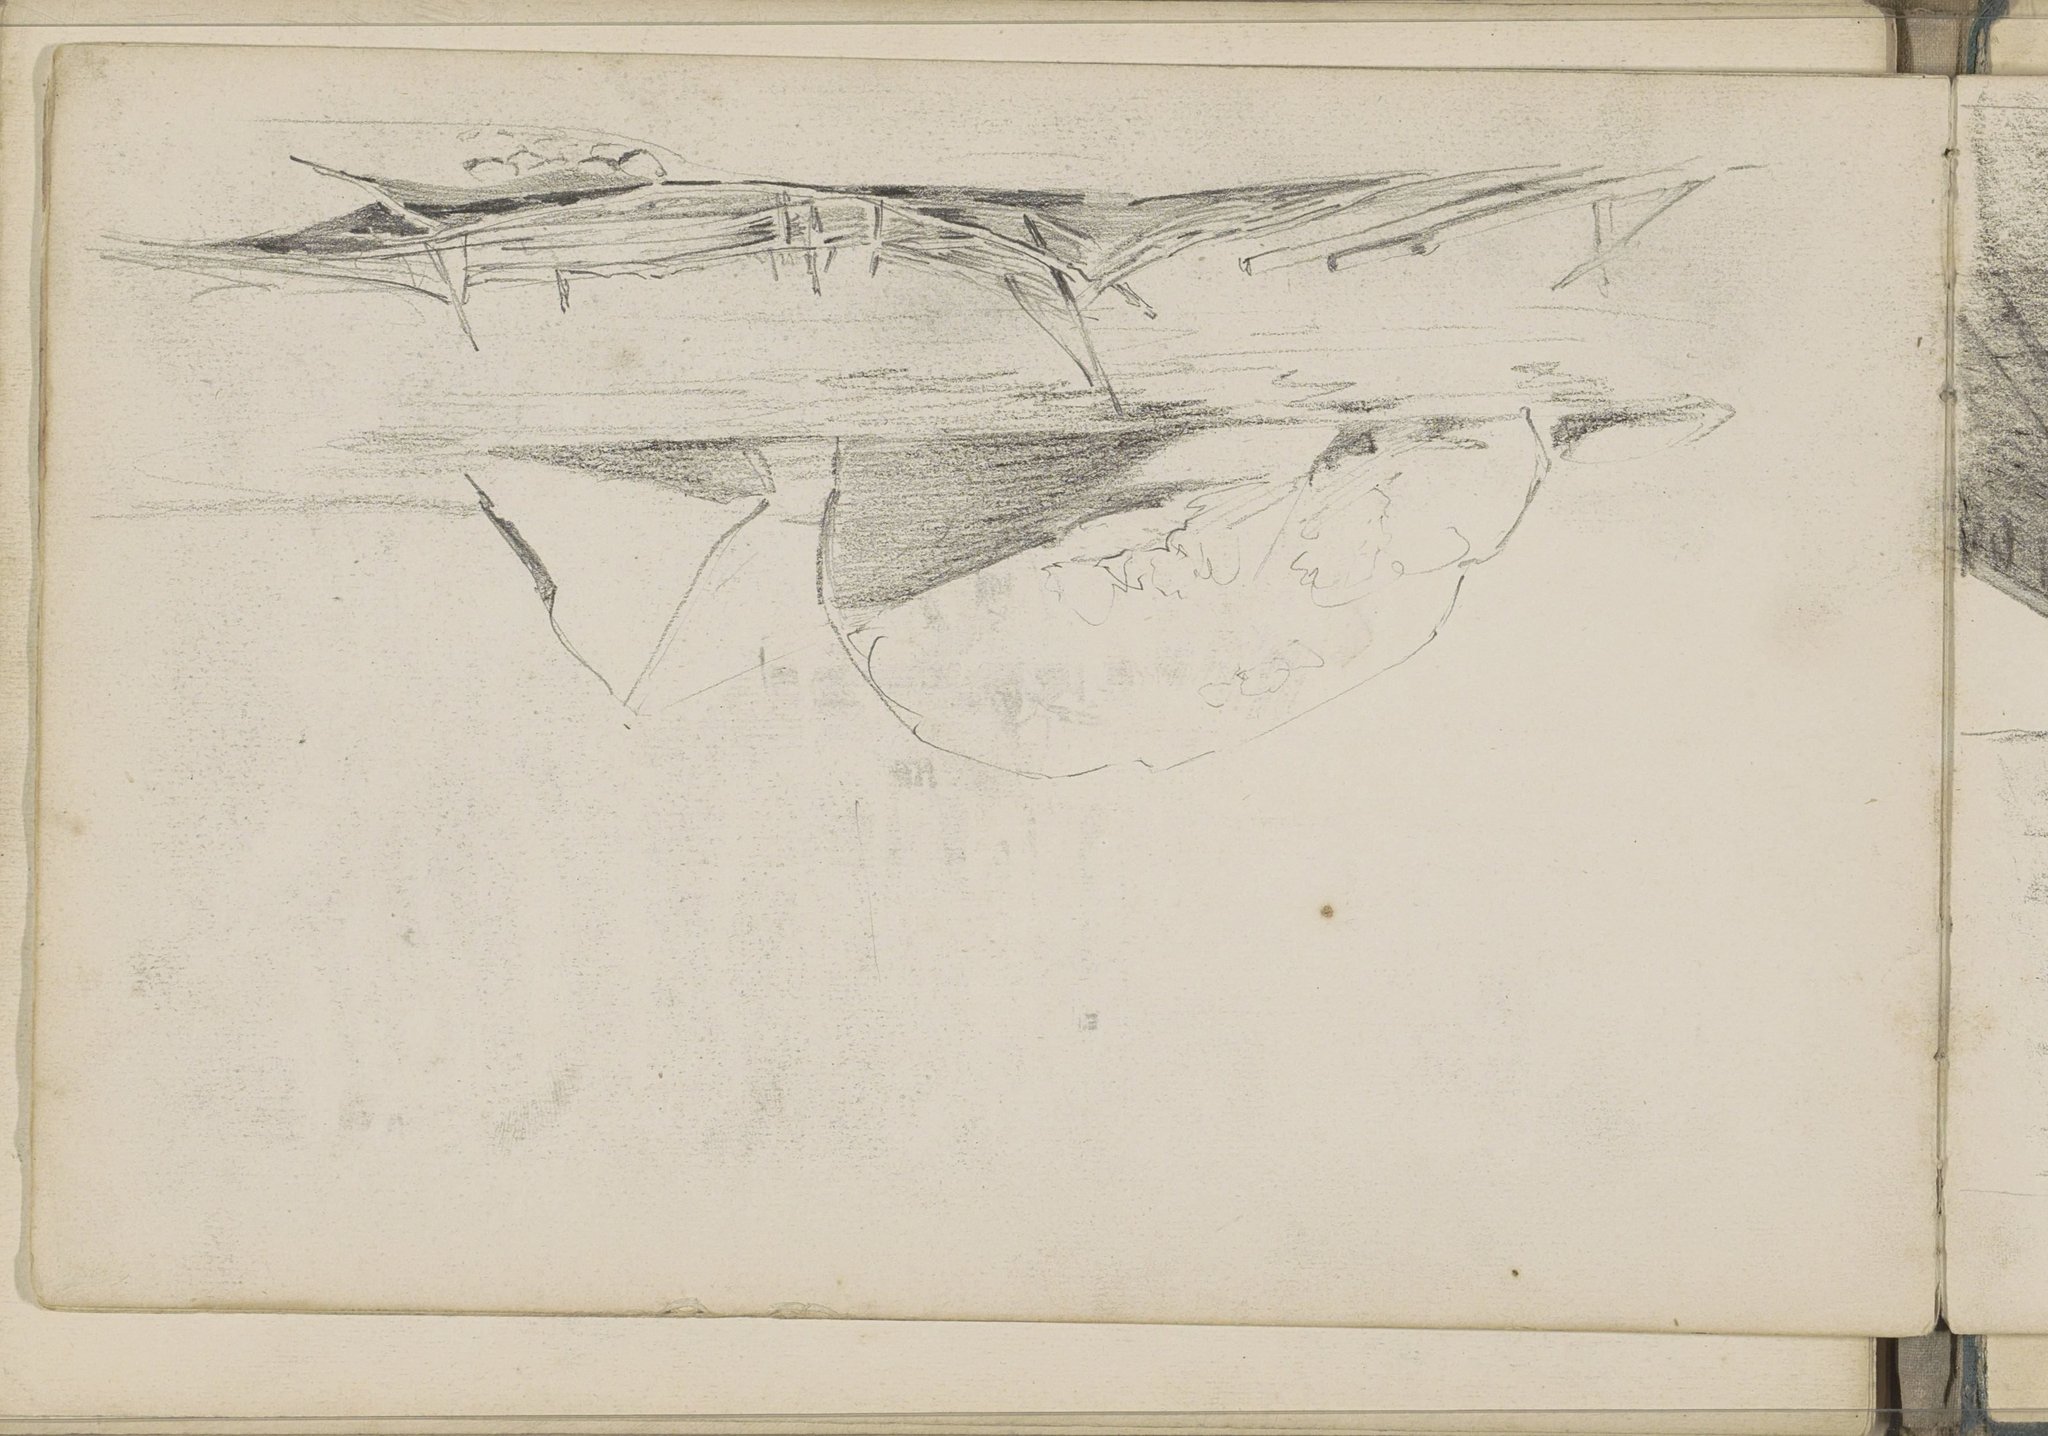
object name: sketchbook leaf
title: Landschap met keien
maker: willem cornelis rip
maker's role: draughtsman, painter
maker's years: 1856-1922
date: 1874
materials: chalk, paper, pencil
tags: landscapes, boulder, stone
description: Blad 31 verso van een los katern uit een schetsboek met 27 losse bladen.